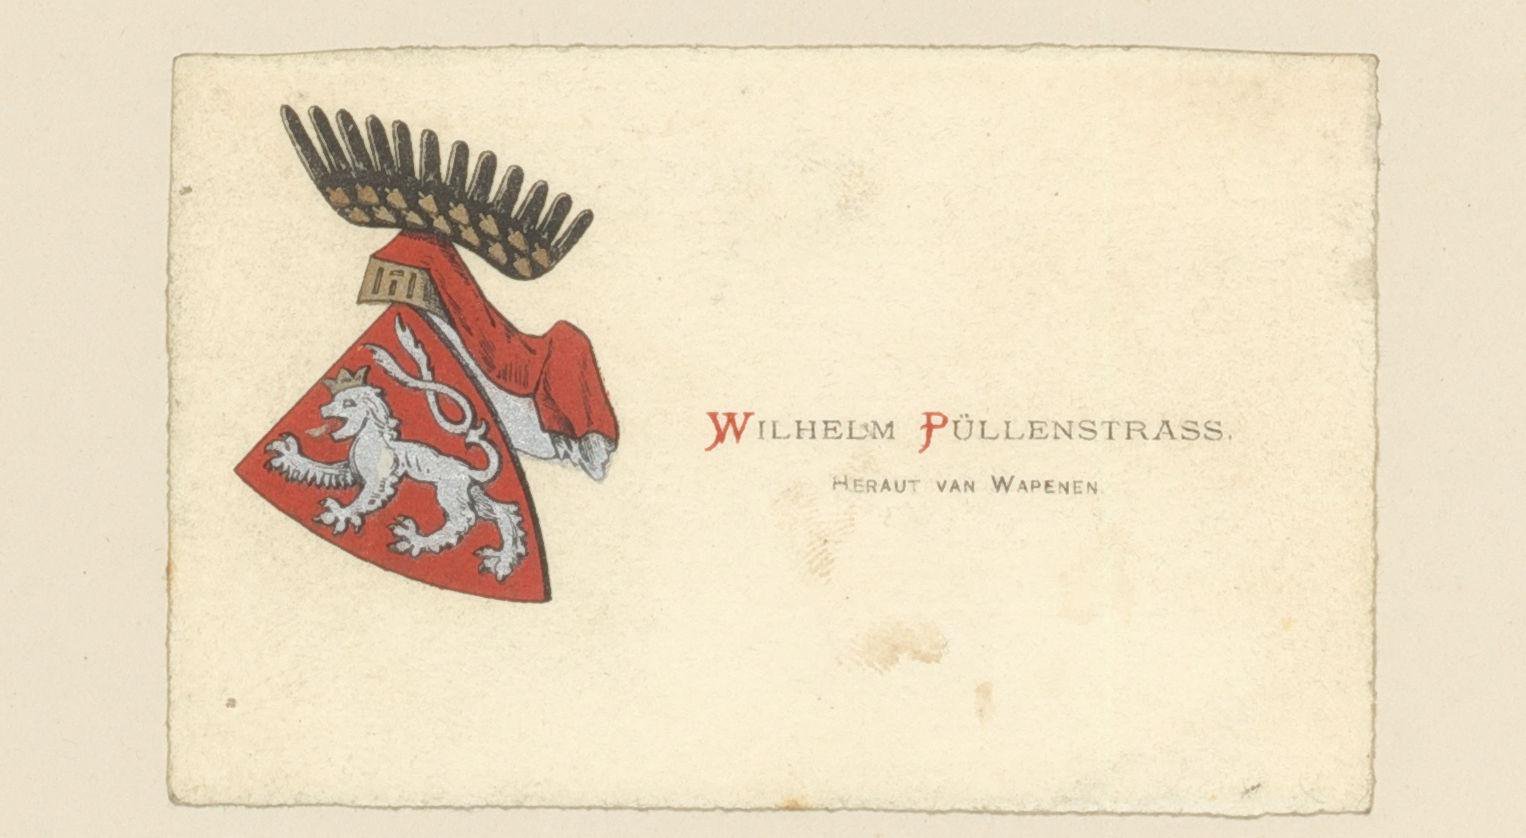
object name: visiting card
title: Visitekaartje van Wilhelm Püllenstrass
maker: Anonymous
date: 1896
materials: paper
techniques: chromolithography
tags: armorial bearing, heraldry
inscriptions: stamp, collector's mark: Lugt 1641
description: Visitekaartje van Wilhelm Püllenstrass. Gemaakt ter gelegenheid van de Ridderhofspelen gehouden tussen 24 en 26 juni 1896 in Utrecht ter gelegenheid van het 52e lustrum van de Universiteit. Het thema van de Ridderhofspelen is het Ridderhofspel te Wenen in 1560. Onderwerpsrubrieken binnen de Atlas Zeden en Gewoonten: Onderwijs en Wetenschappen, Studentenleven.